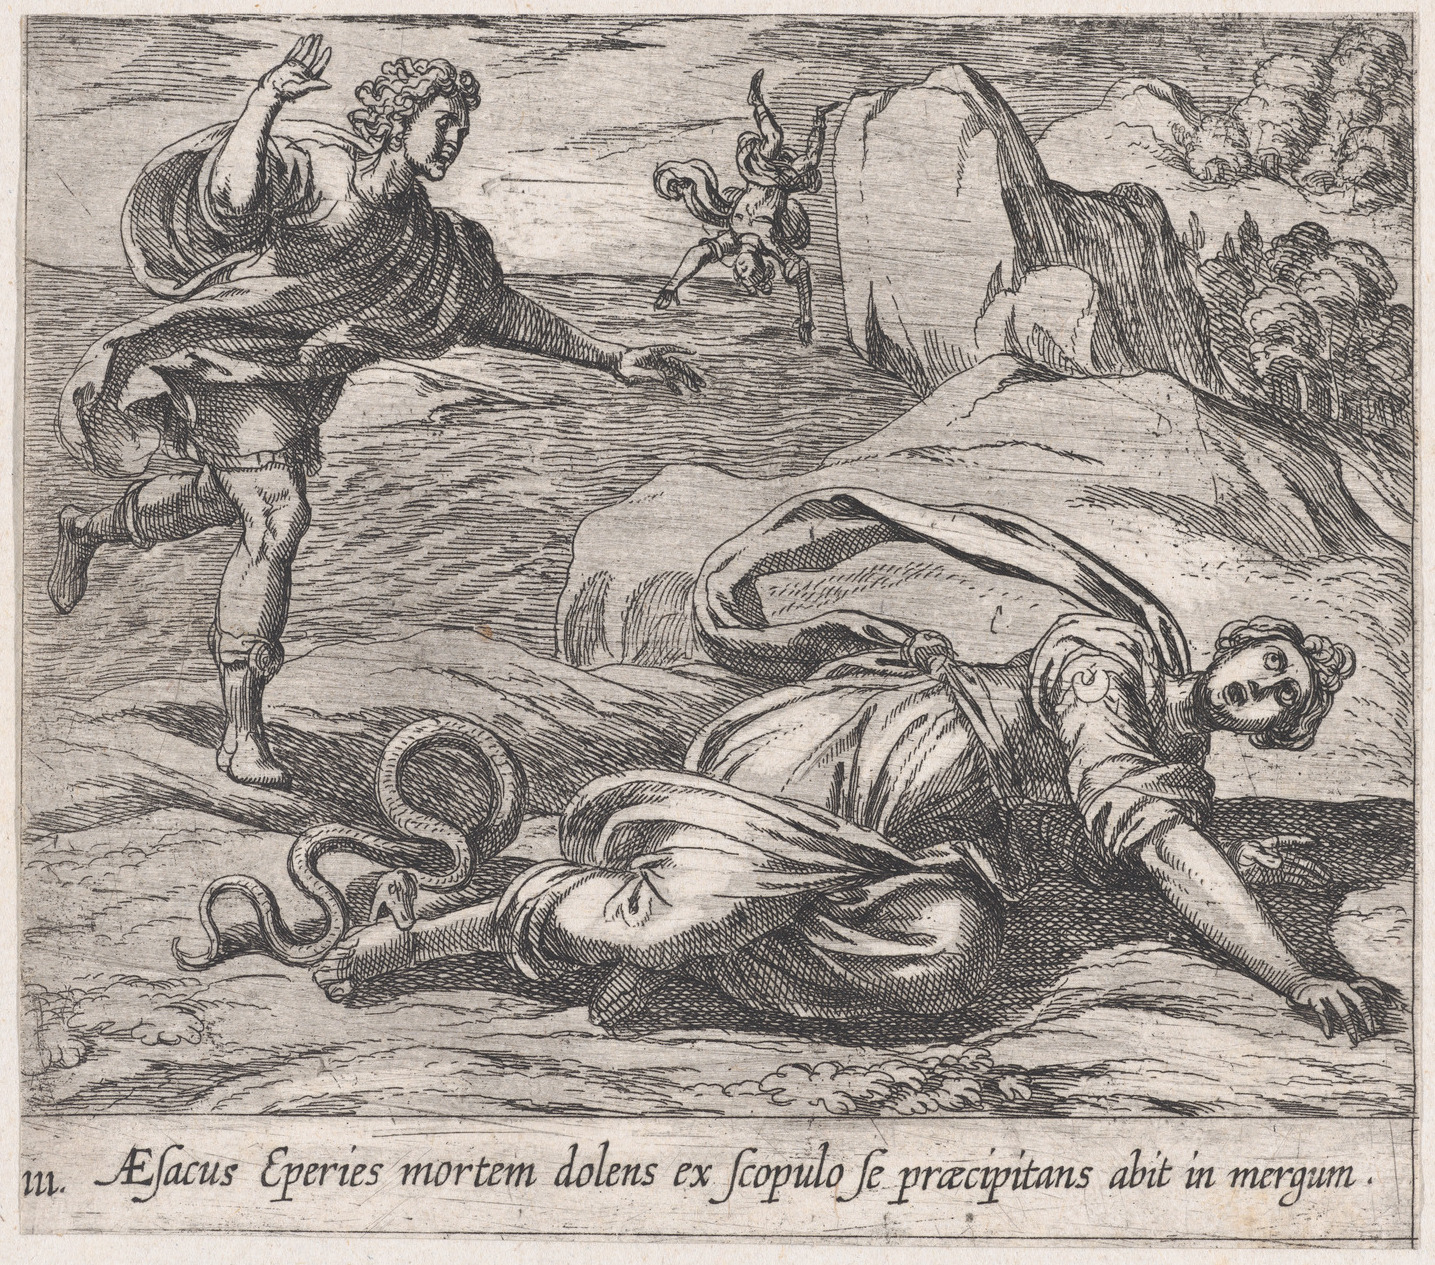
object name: print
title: Plate 111: Aesacus and Hespeia (Aesacus Eperies mortem dolens ex scopulo se praecipitans abit in mergum), from Ovid's 'Metamorphoses'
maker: antonio tempesta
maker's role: artist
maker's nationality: italian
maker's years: 1555-1630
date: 1606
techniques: etching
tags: men,women,snakes